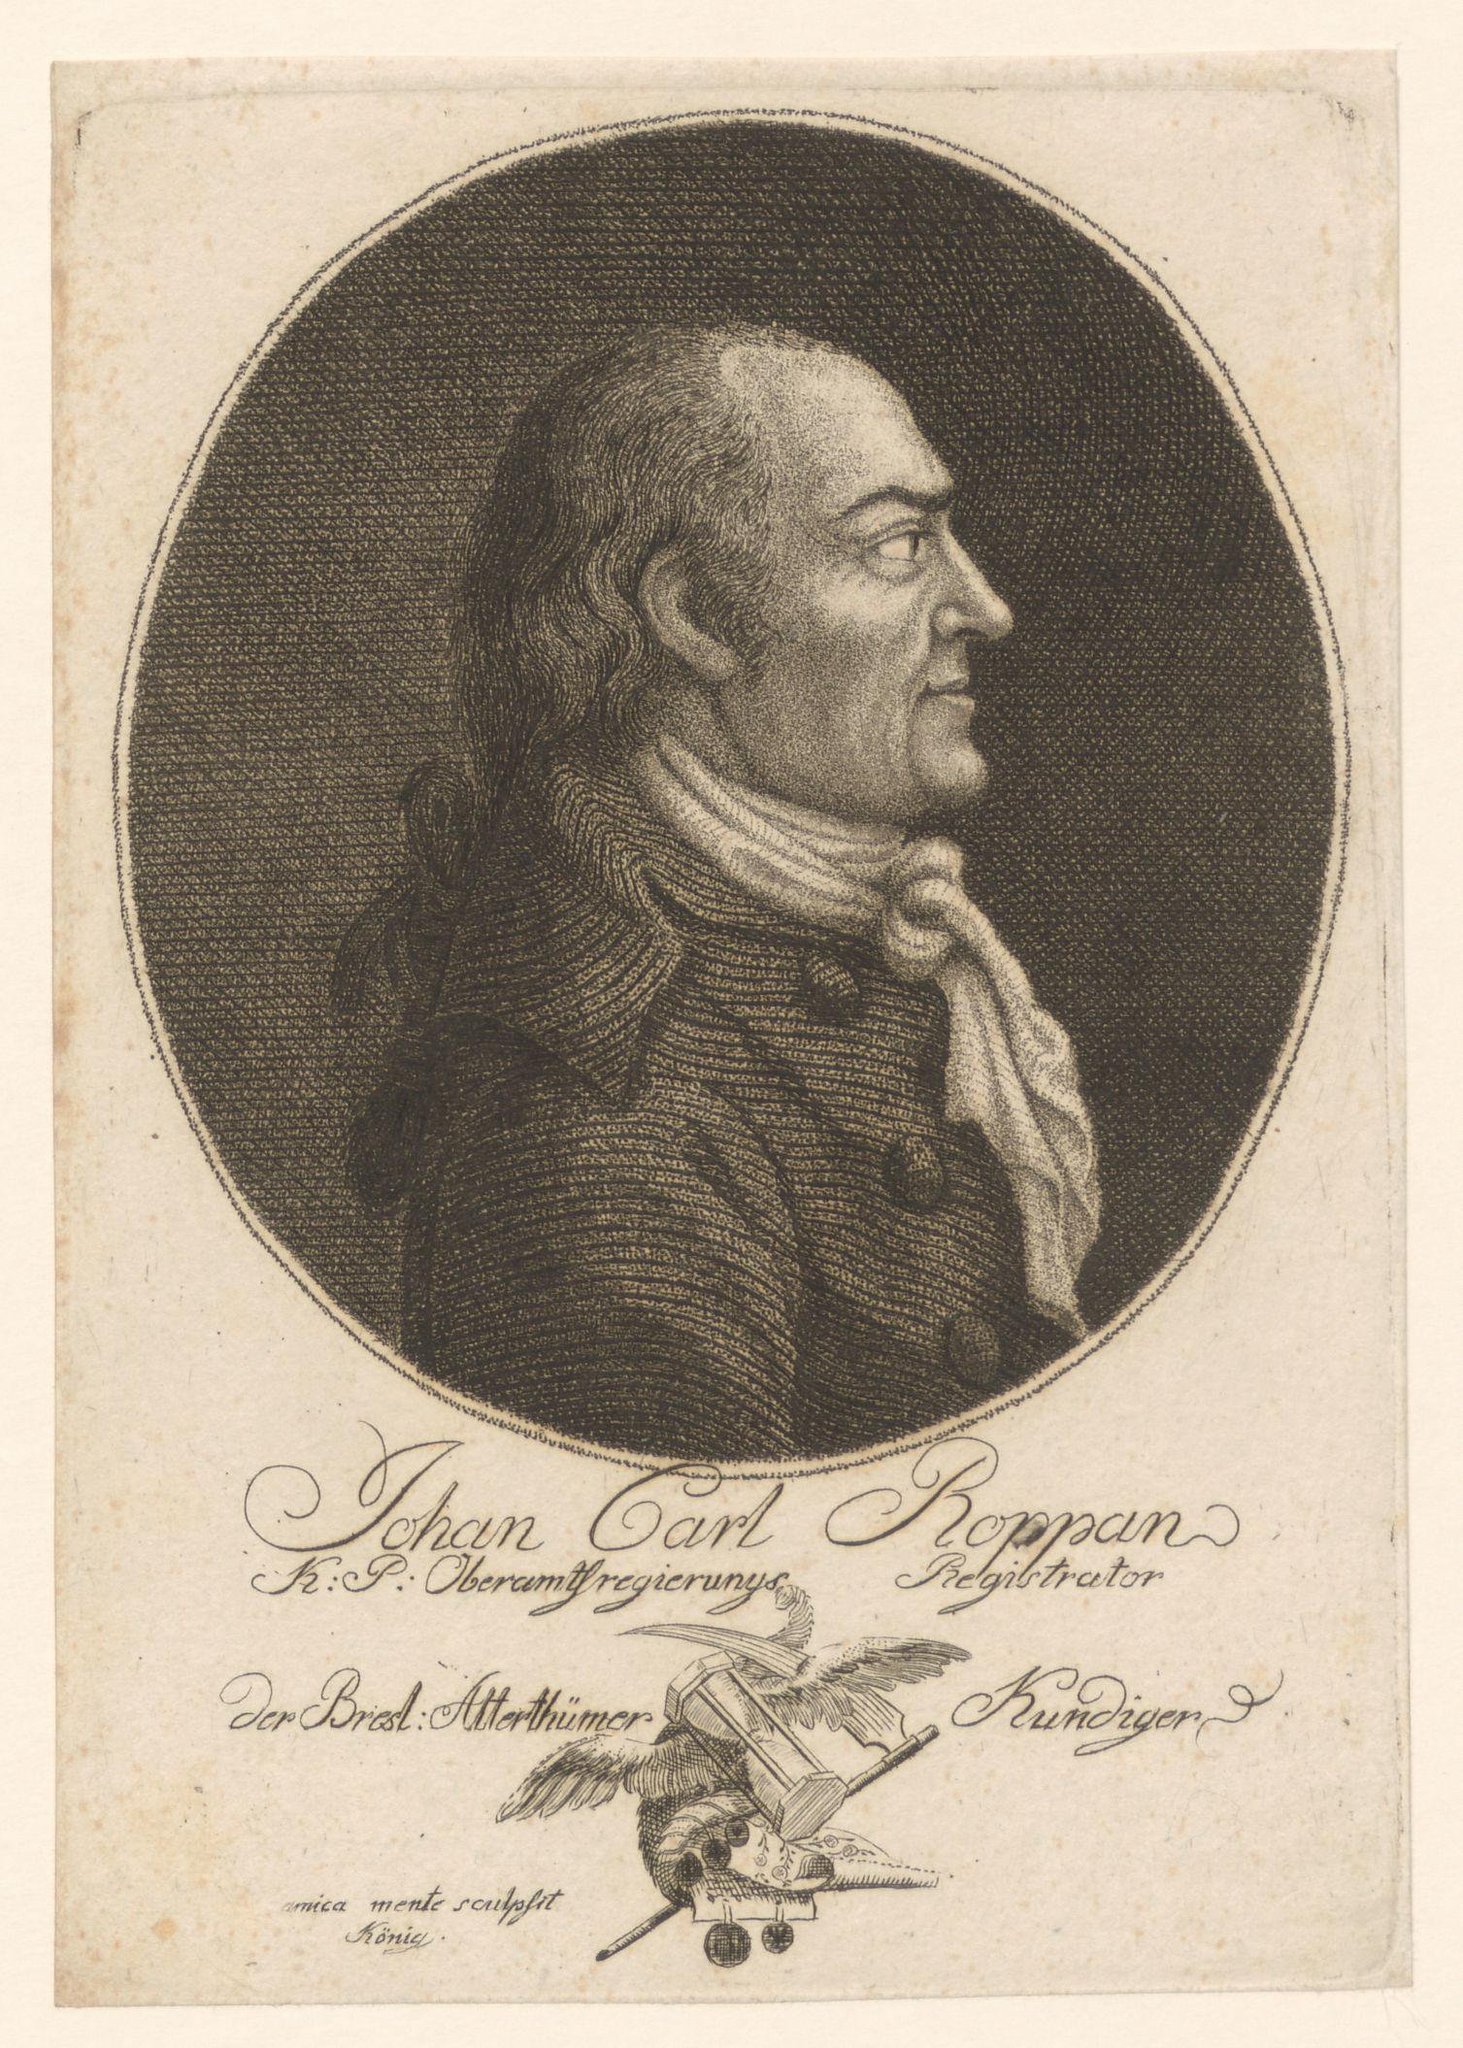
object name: print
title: Portret van Johann Carl Roppan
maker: anton balthazar könig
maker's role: print maker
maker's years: 1693-1773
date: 1704-1773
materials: paper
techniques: stippling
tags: official; civil servant; functionary (in general), historical persons, counsellor, fugacity of time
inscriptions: collector's mark: Lugt 2228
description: Tekst in het Duits in de ondermarge. Onderaan een allegorie op tijd en vergankelijkheid.